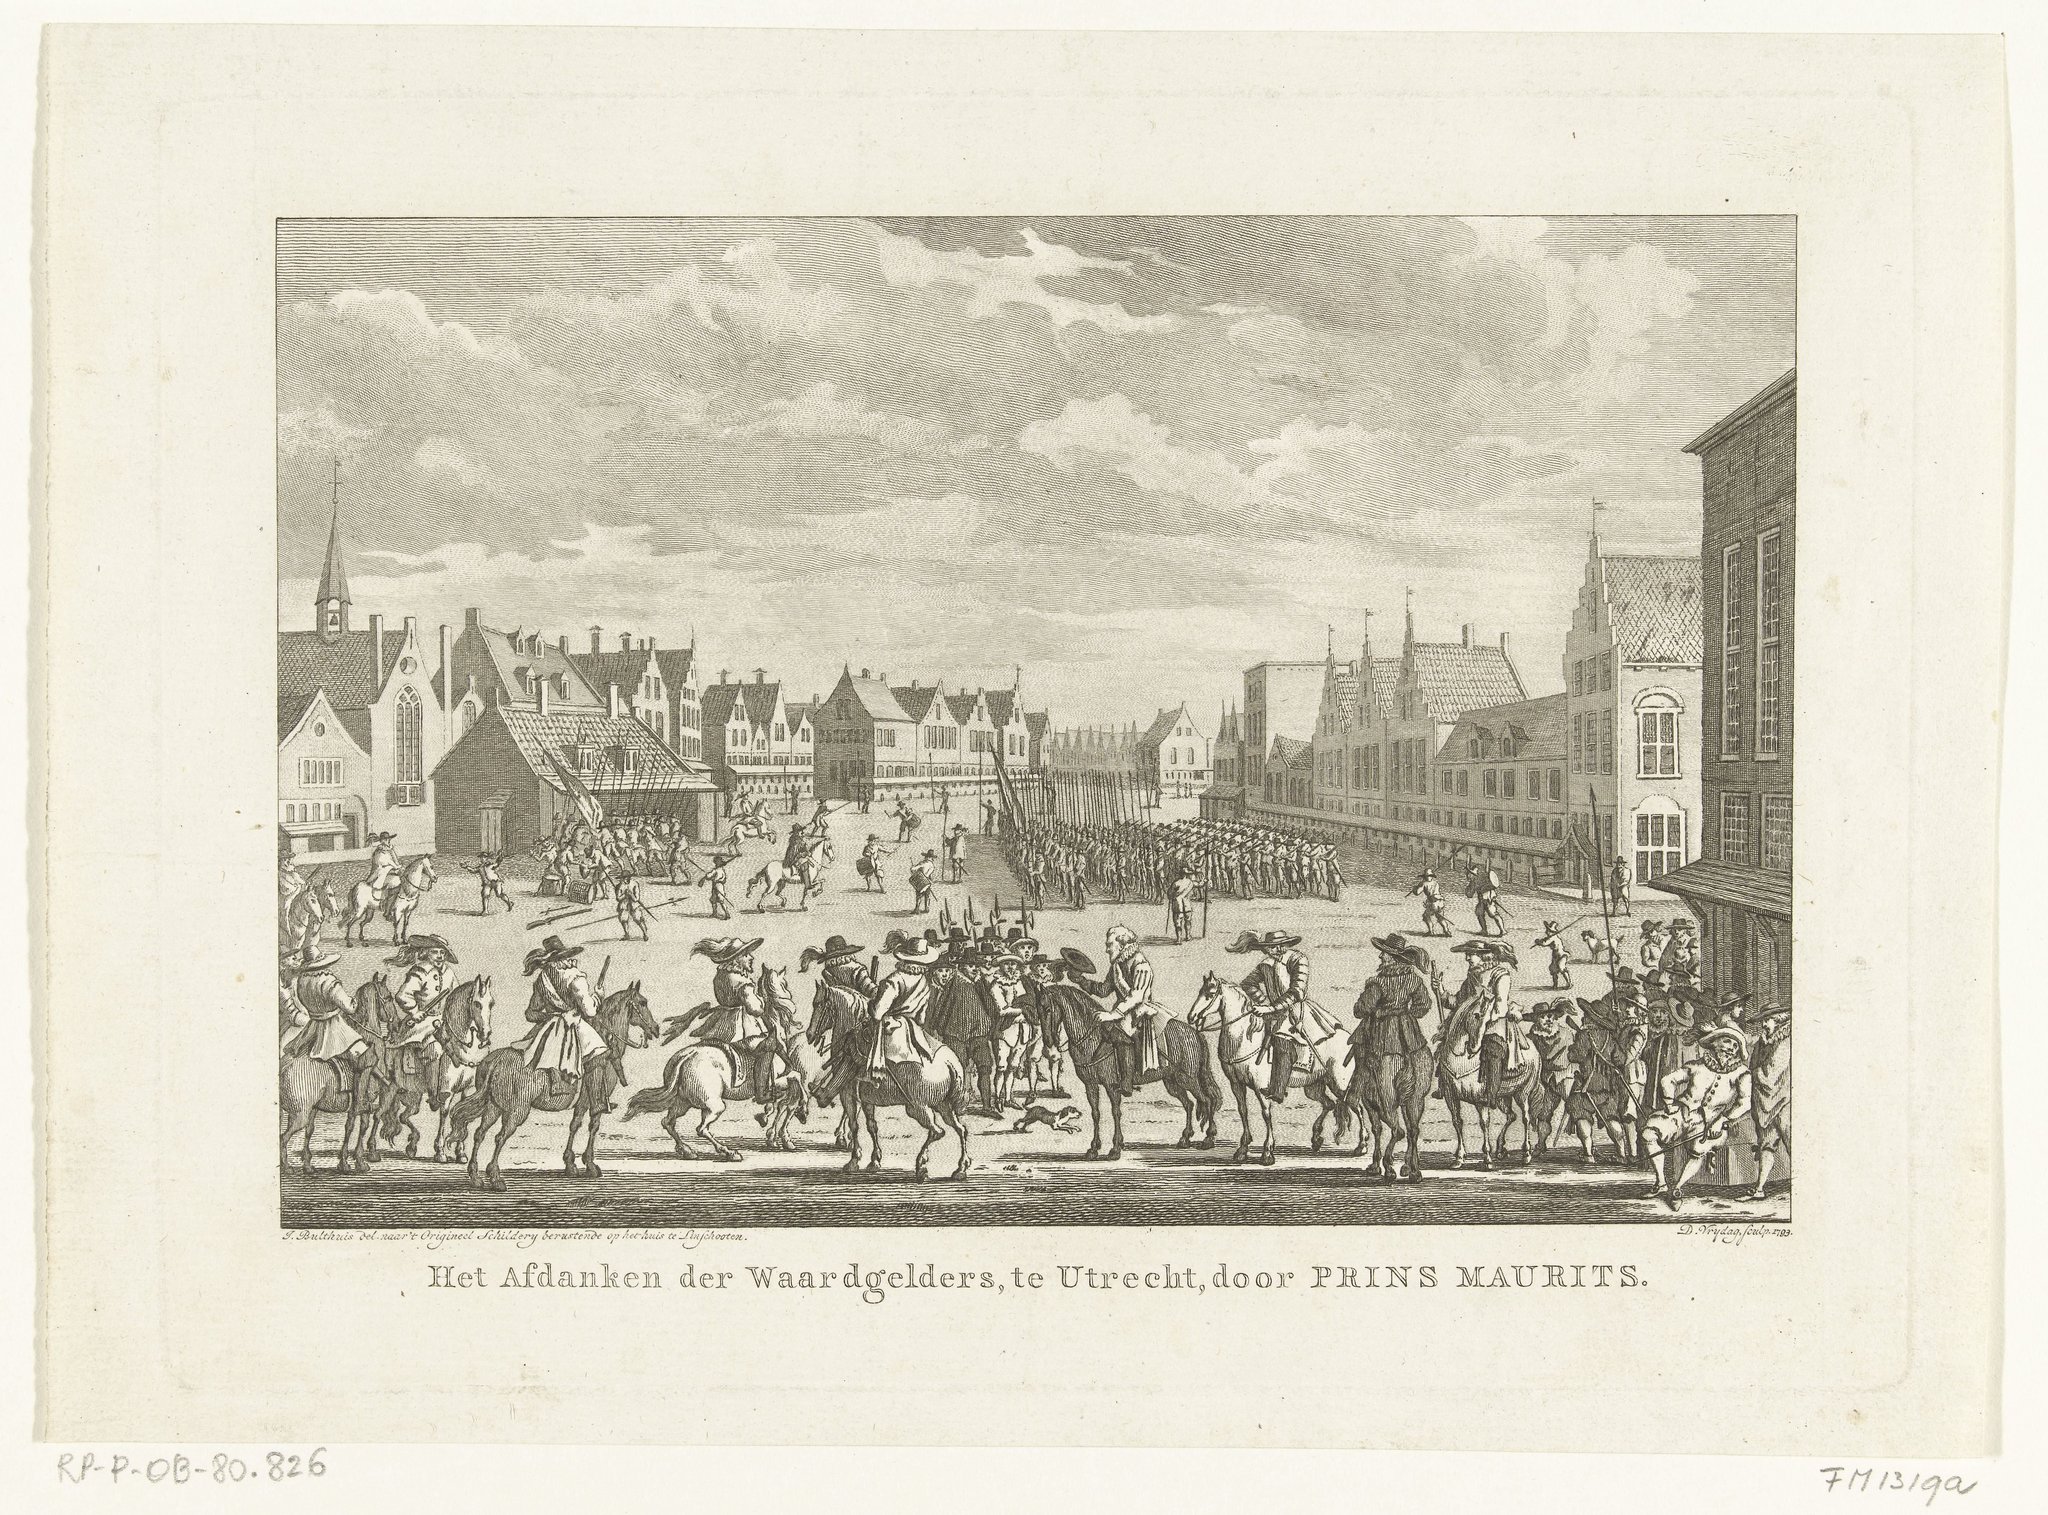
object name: print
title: Het afdanken der Waardgelders, te Utrecht, door Prins Maurits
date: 1793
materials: paper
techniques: etching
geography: netherlands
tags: maurice (prince of orange), demobilization, warfare; military affairs (+ mercenary troops, e.g.: lansquenets), assembling of military forces; mobilization, troop concentration, etc.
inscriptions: date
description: De afdanking van de waardgelders op bevel van prins Maurits, 31 juli 1618. De troepen staan opgesteld op de Neude te Utrecht, op de voorgrond Maurits met gevolg en officieren te paard.